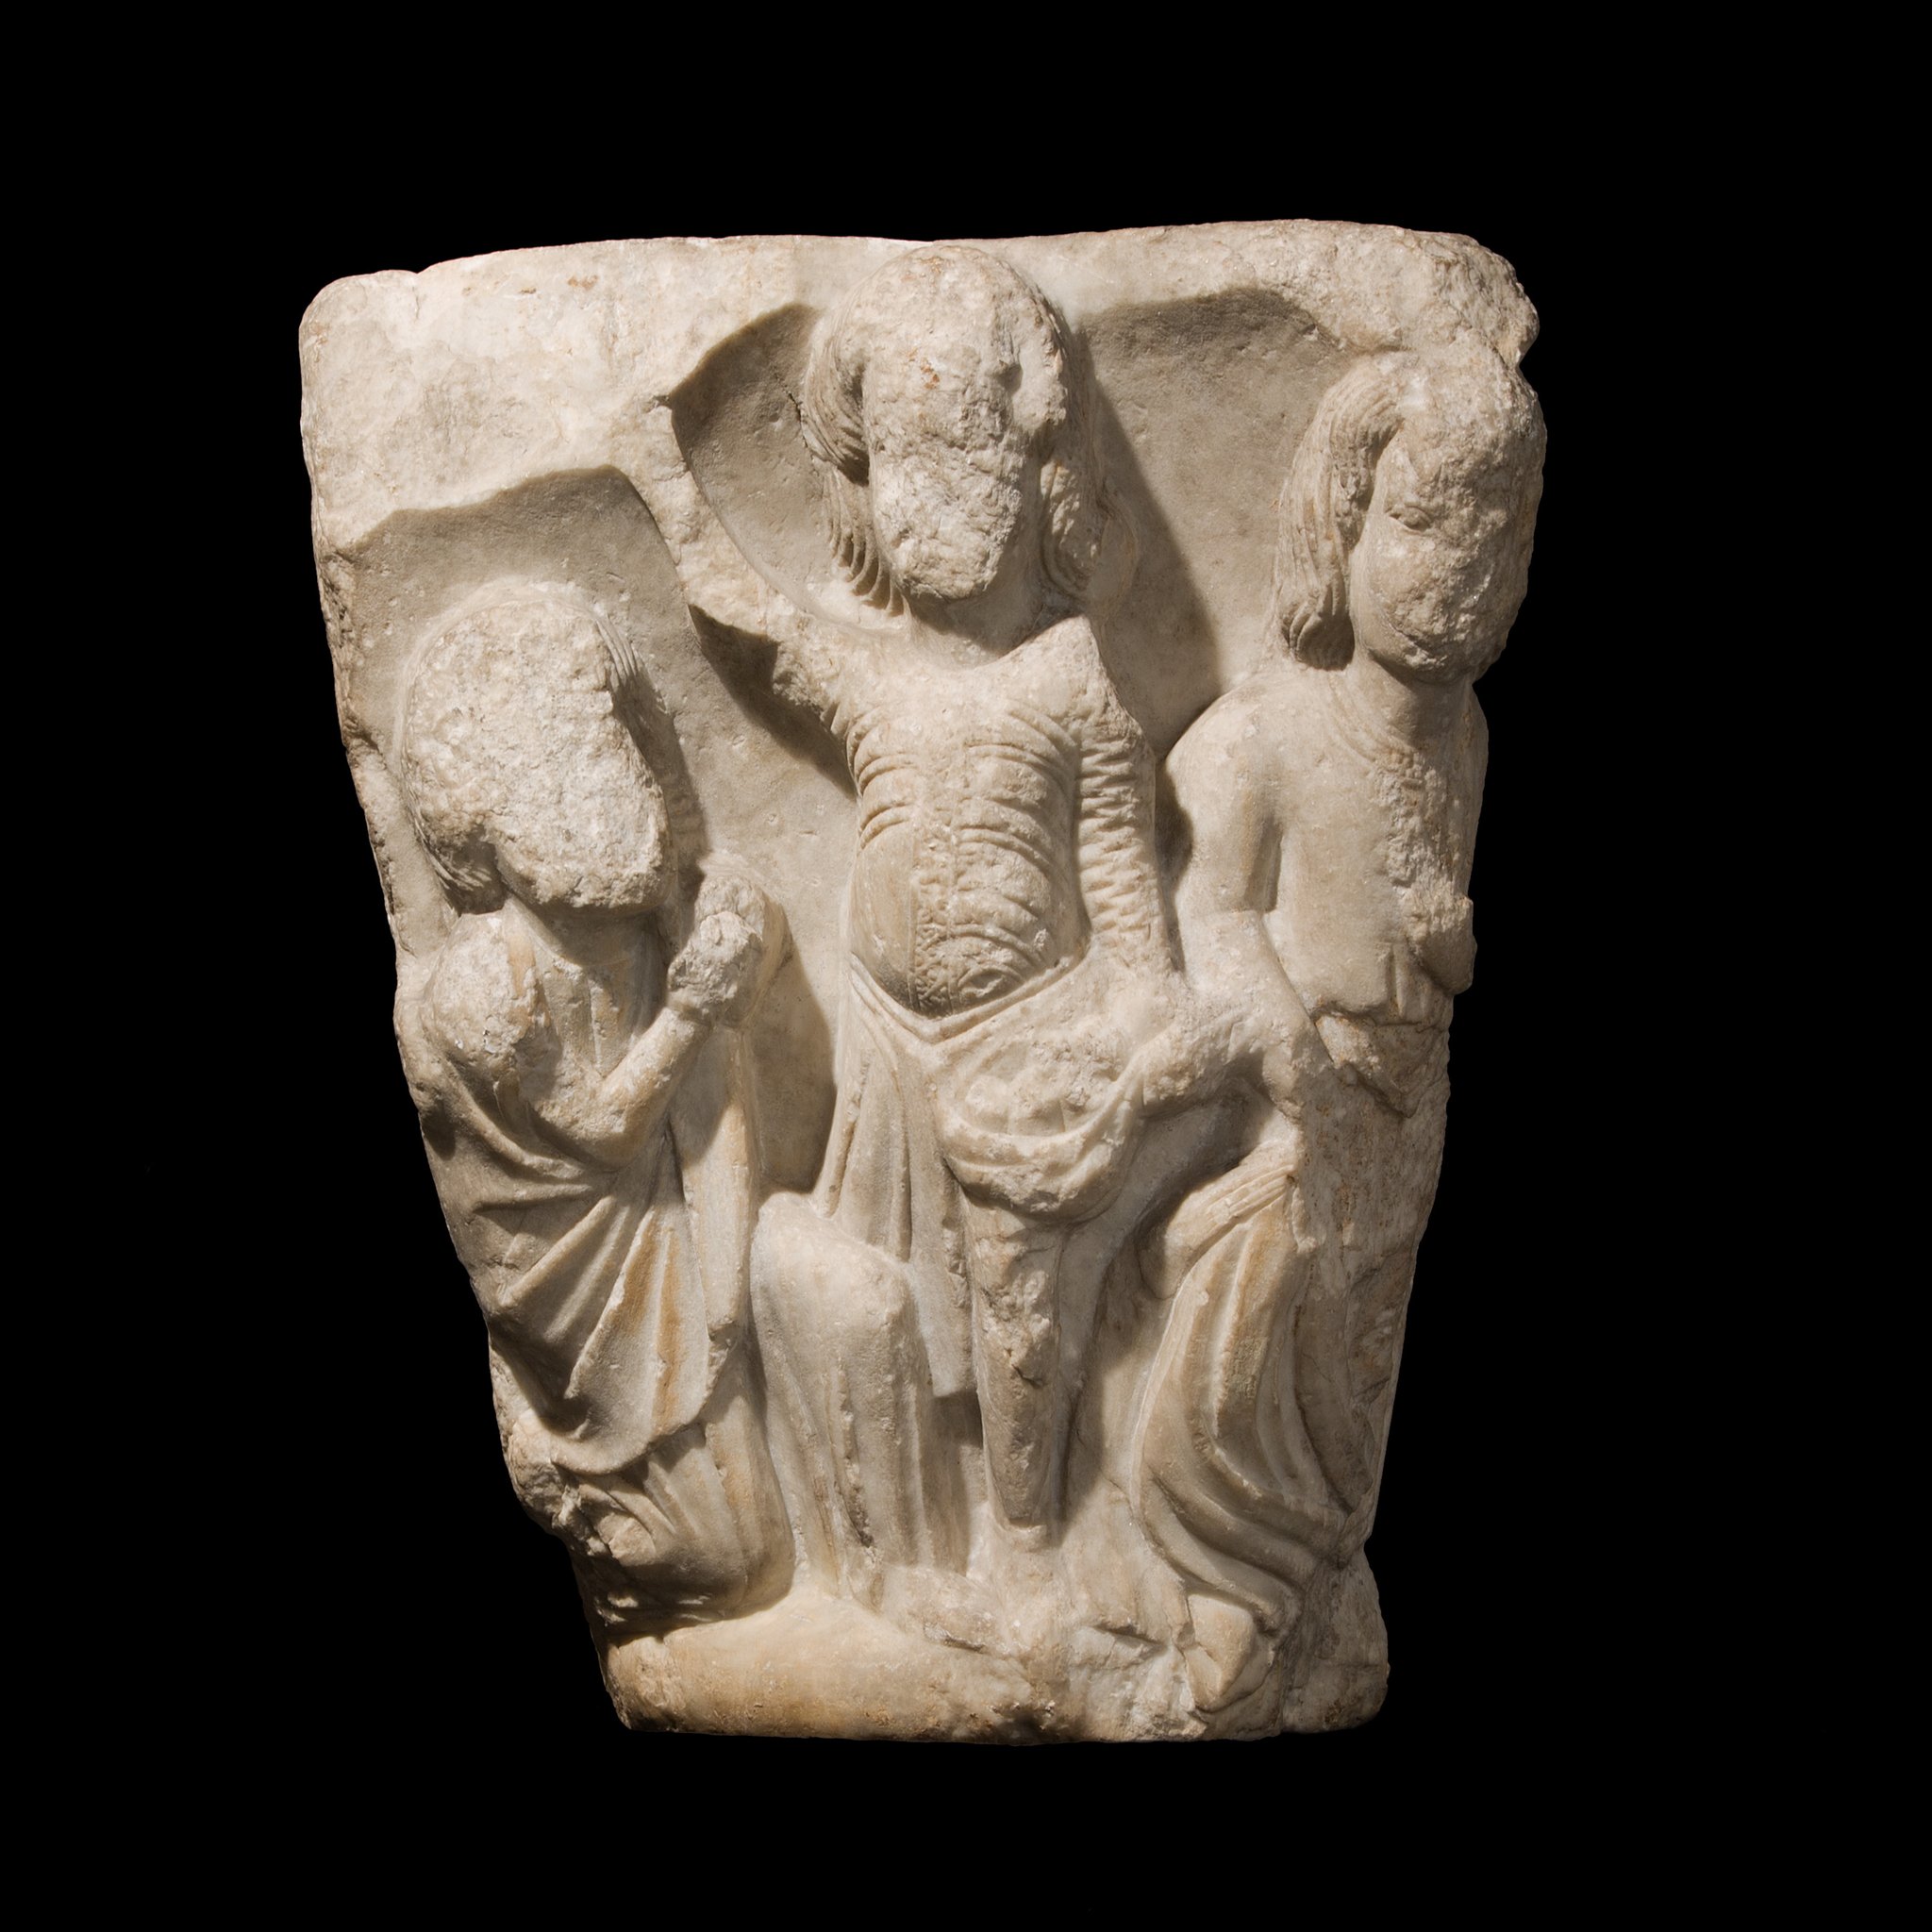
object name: capital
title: Double Capital Fragment with the Stoning of St. Stephen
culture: french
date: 1101-1200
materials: marble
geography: france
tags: saints